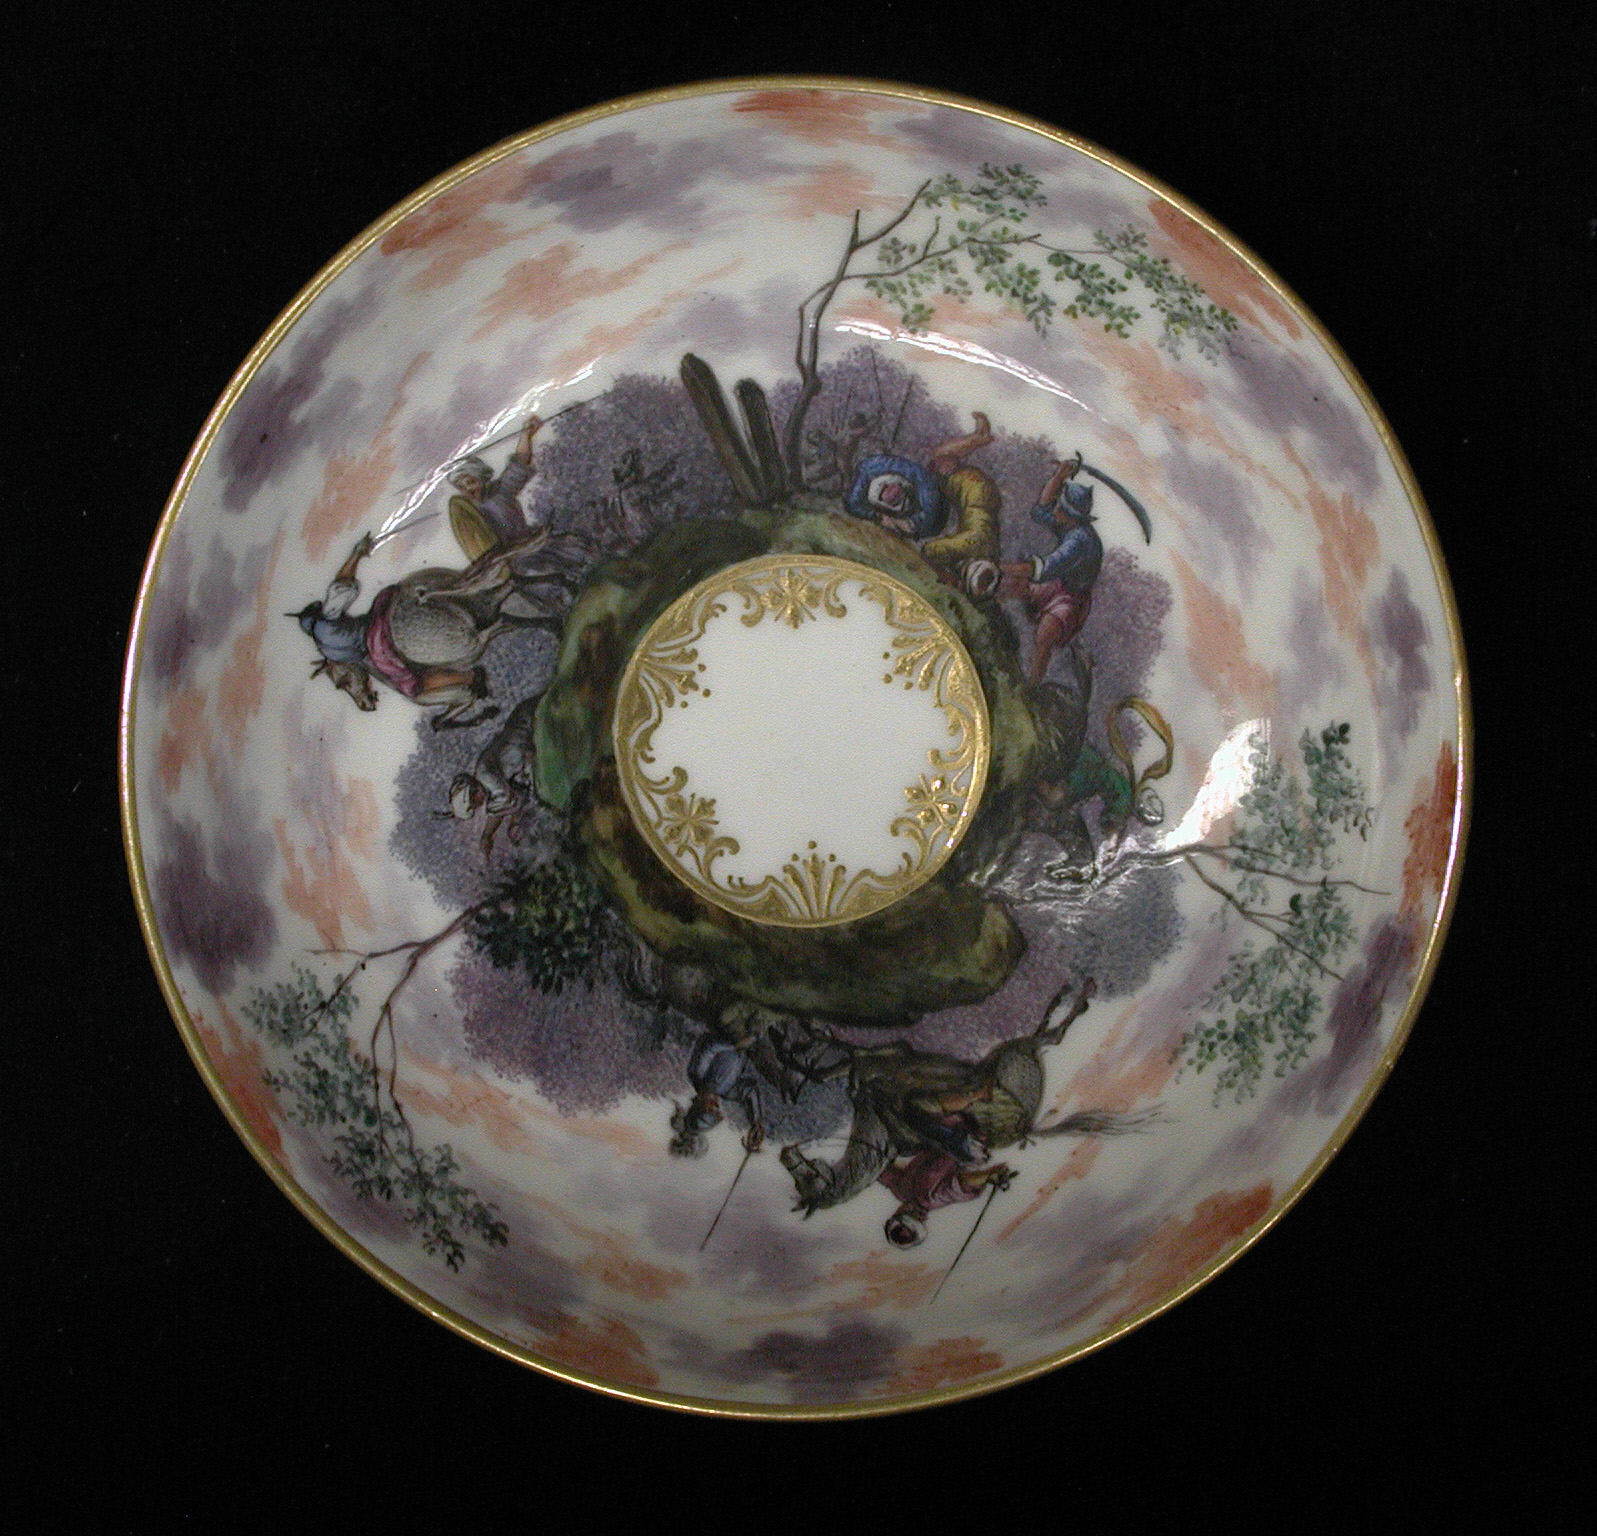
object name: saucer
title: Saucer (part of a service)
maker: capodimonte porcelain manufactory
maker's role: manufactory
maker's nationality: italian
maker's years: 1740-1759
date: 1743-1759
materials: soft paste porcelain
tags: swords,horses,trees